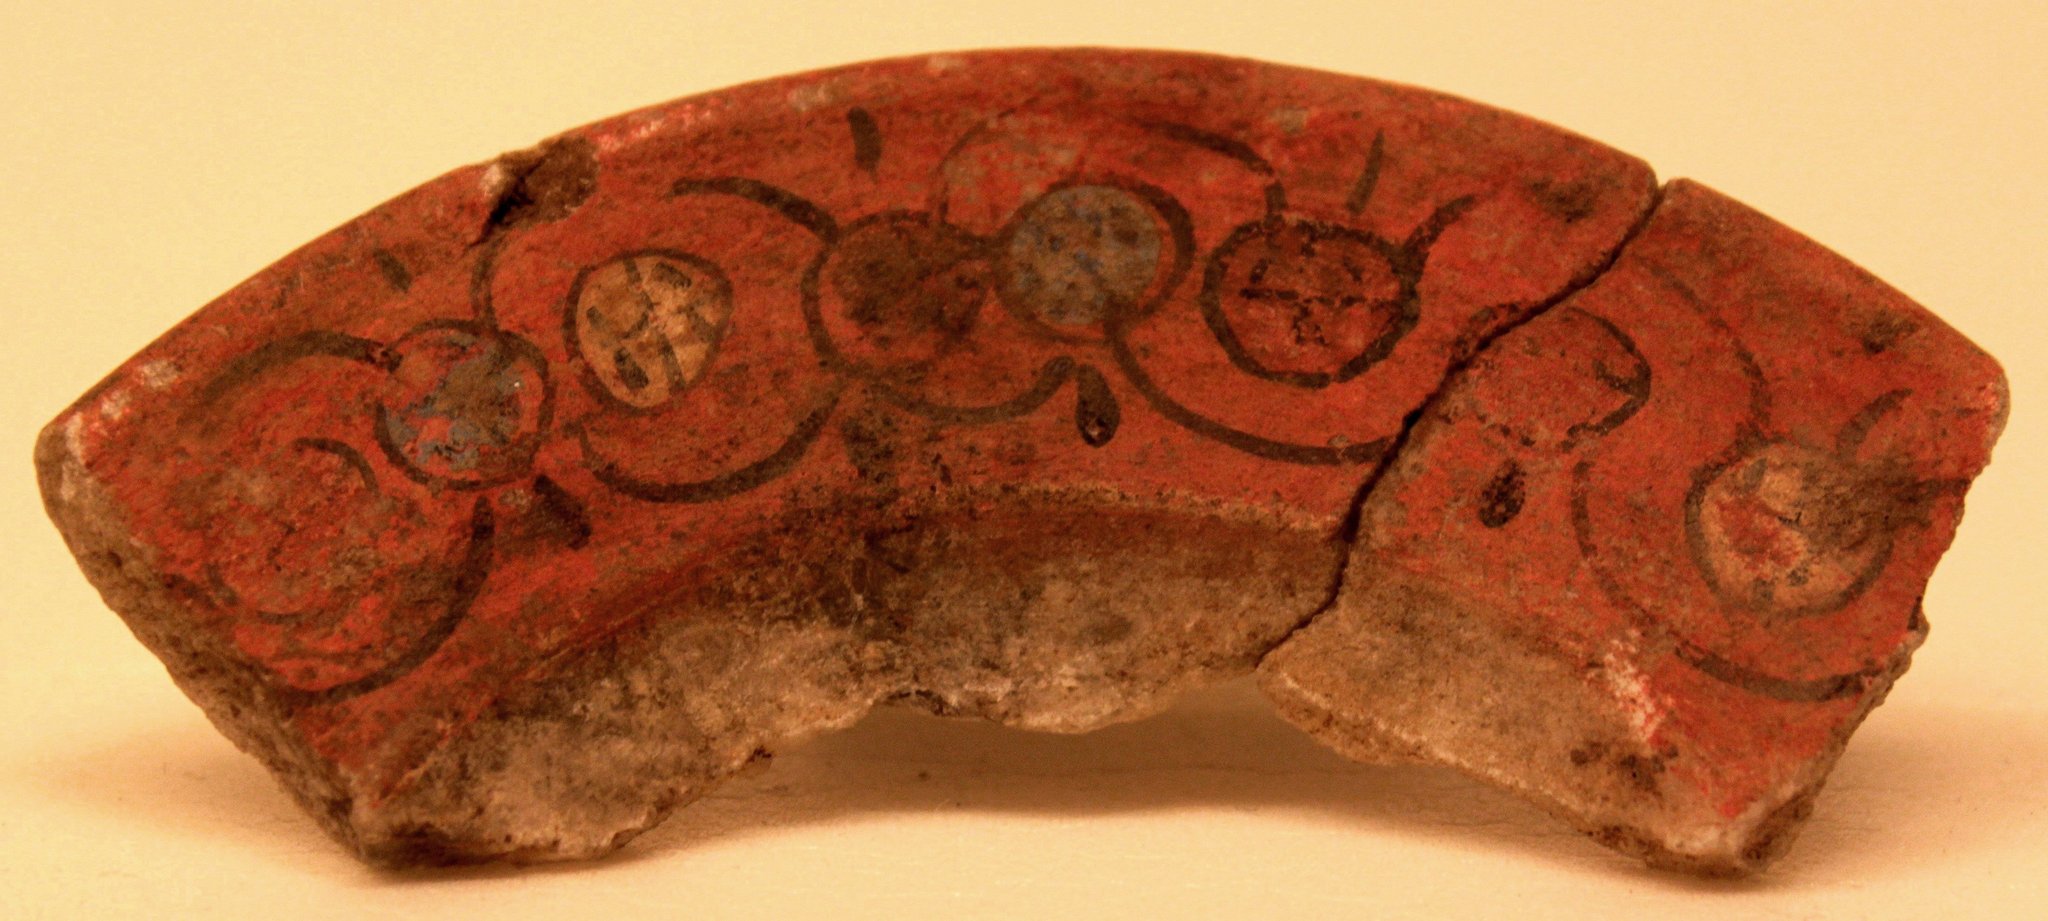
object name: fragment of a dish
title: Fragment of Dish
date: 801-1000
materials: alabaster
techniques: carving, painting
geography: iran